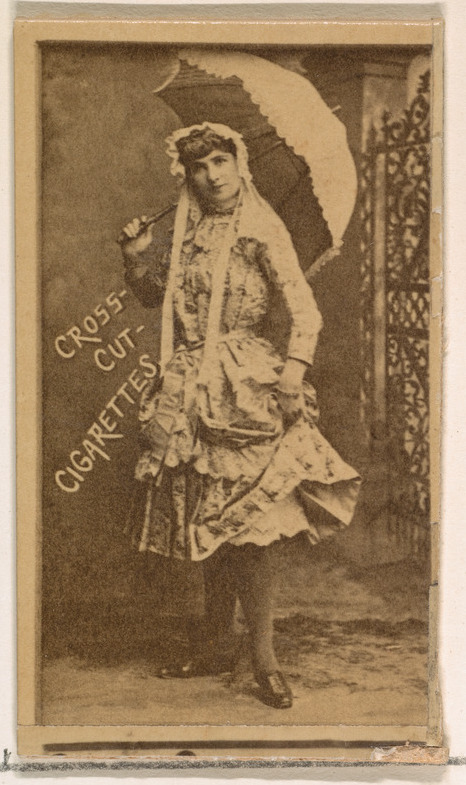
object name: print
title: Myra Goodman, from the Actors and Actresses series (N145-1) issued by Duke Sons & Co. to promote Cross Cut Cigarettes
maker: w. duke, sons & co.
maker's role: publisher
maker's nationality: american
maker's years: 1870-1920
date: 1880-1889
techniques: albumen silver print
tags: portraits,women,actresses